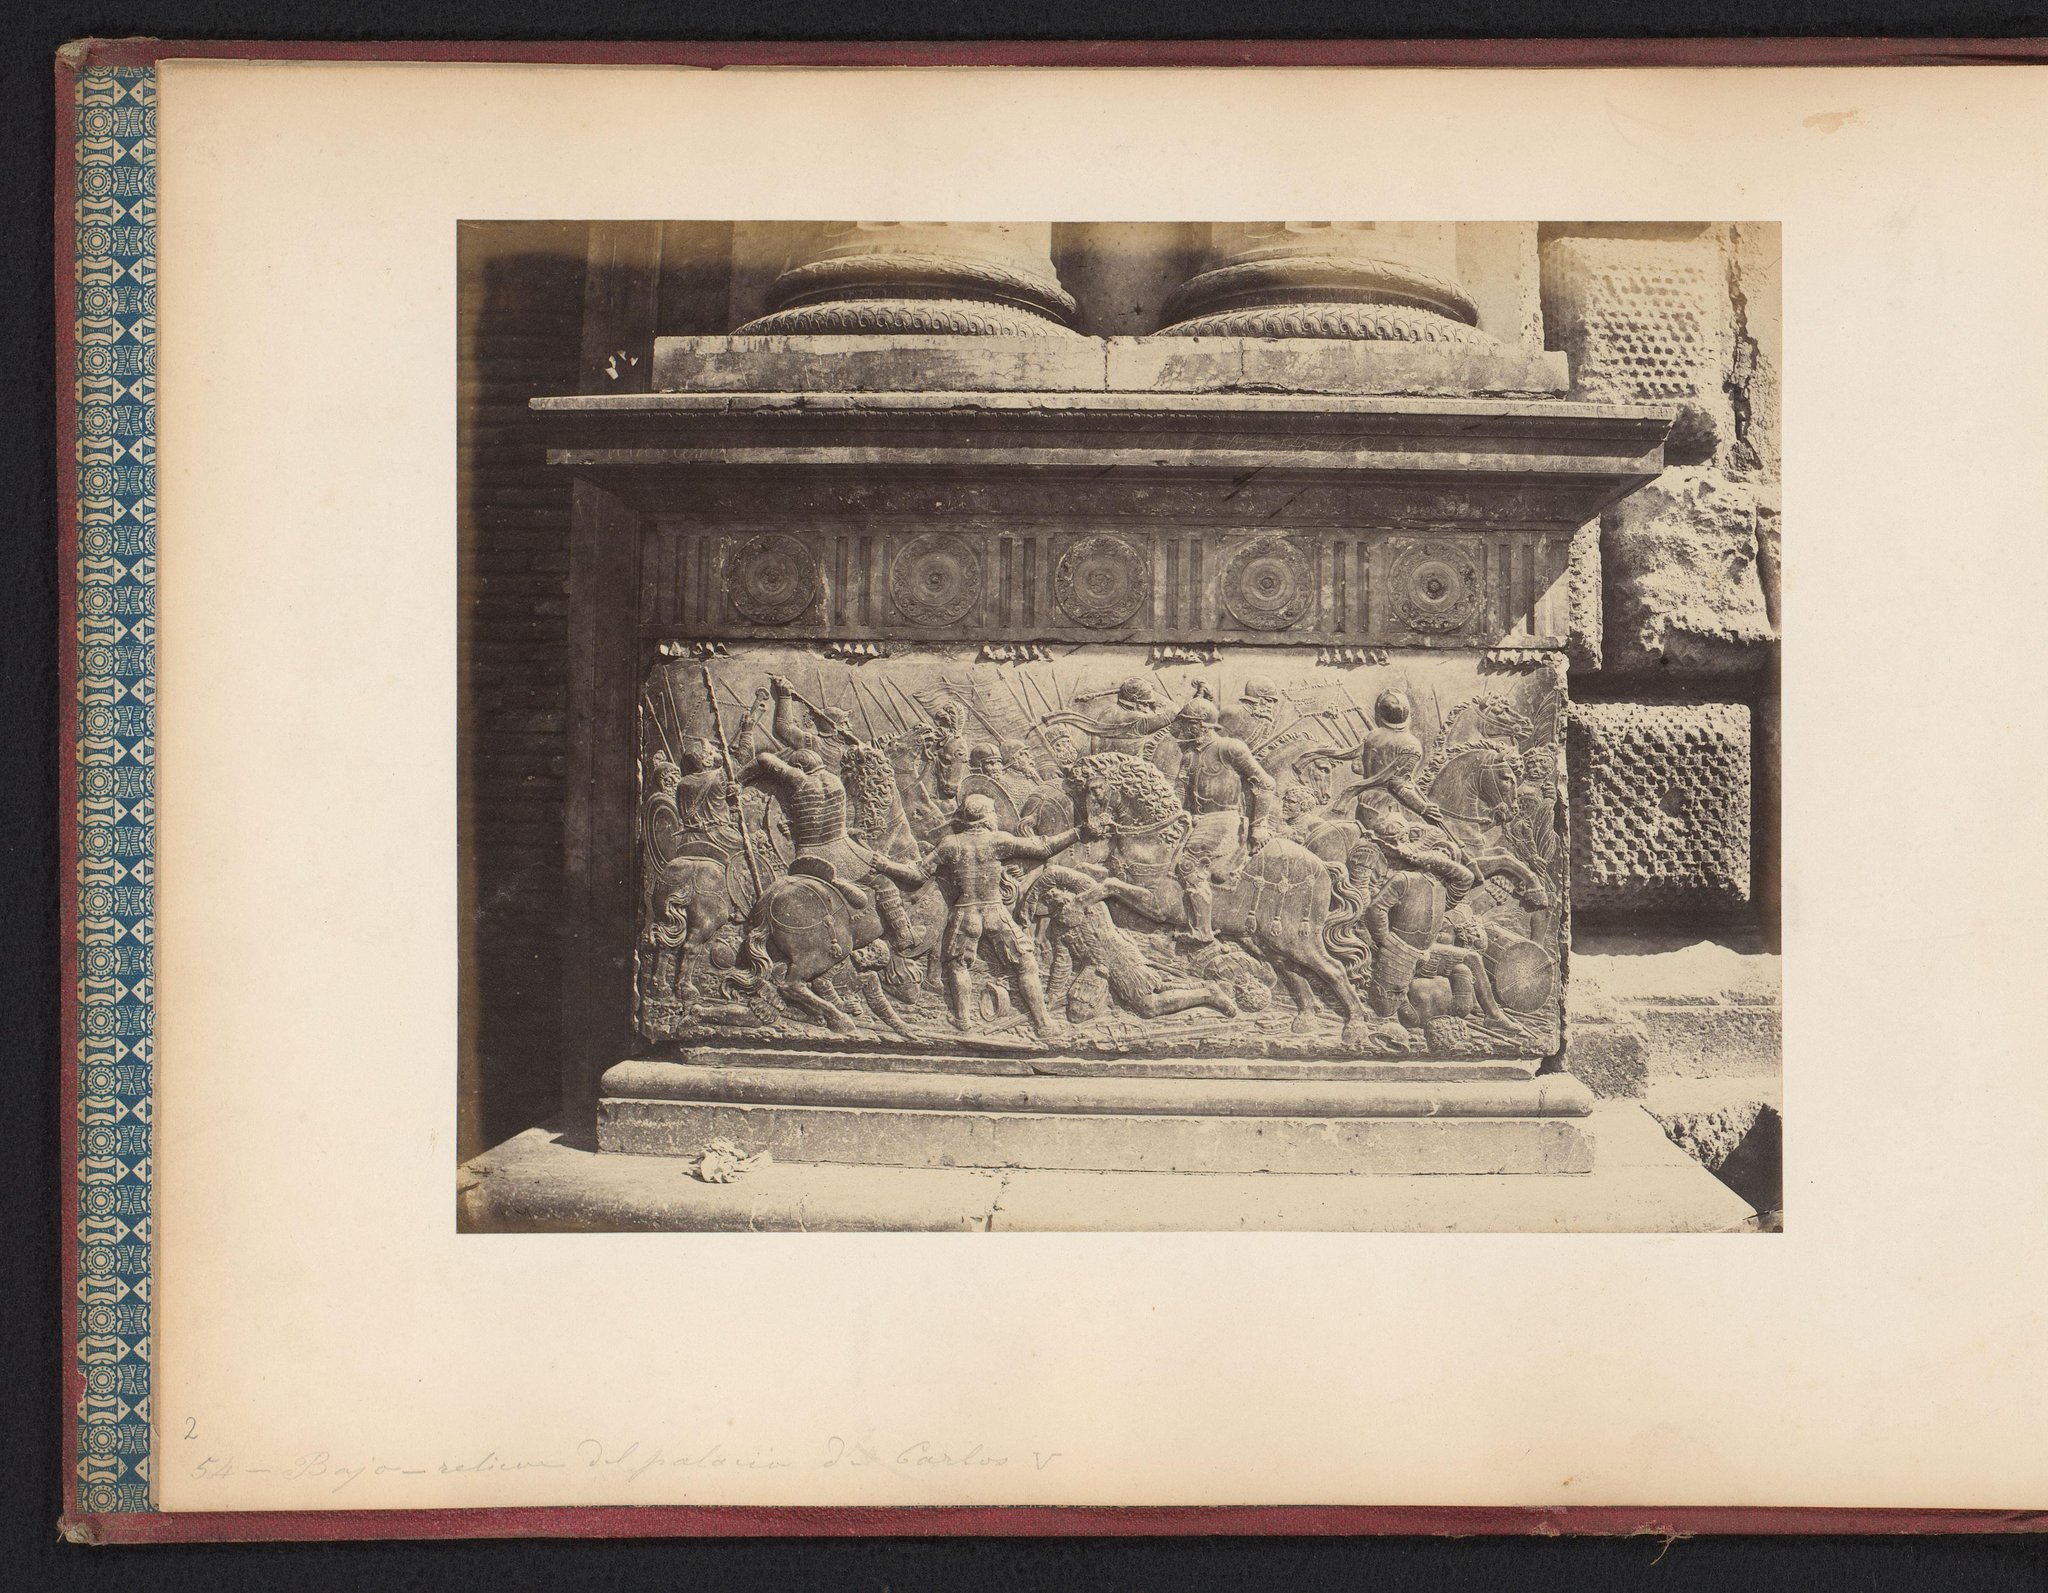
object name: photograph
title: Bajo-relieve del palacio de Carlos V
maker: c maufsaise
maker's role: fotograaf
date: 1906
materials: paper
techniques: albumen print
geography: granada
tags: art (+ relief ~ sculpture)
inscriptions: number: ‘54’